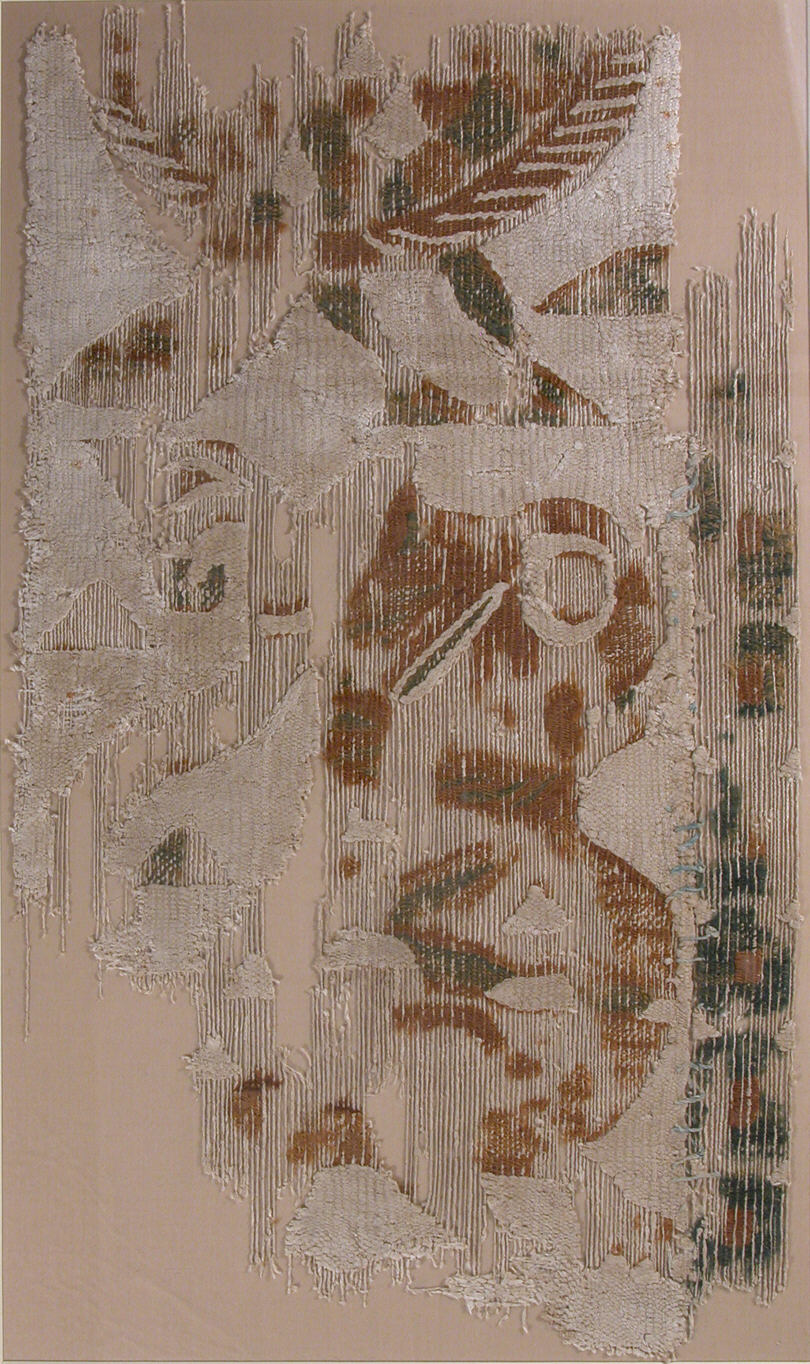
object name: textile fragment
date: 801-1000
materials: linen, wool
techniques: weave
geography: egypt